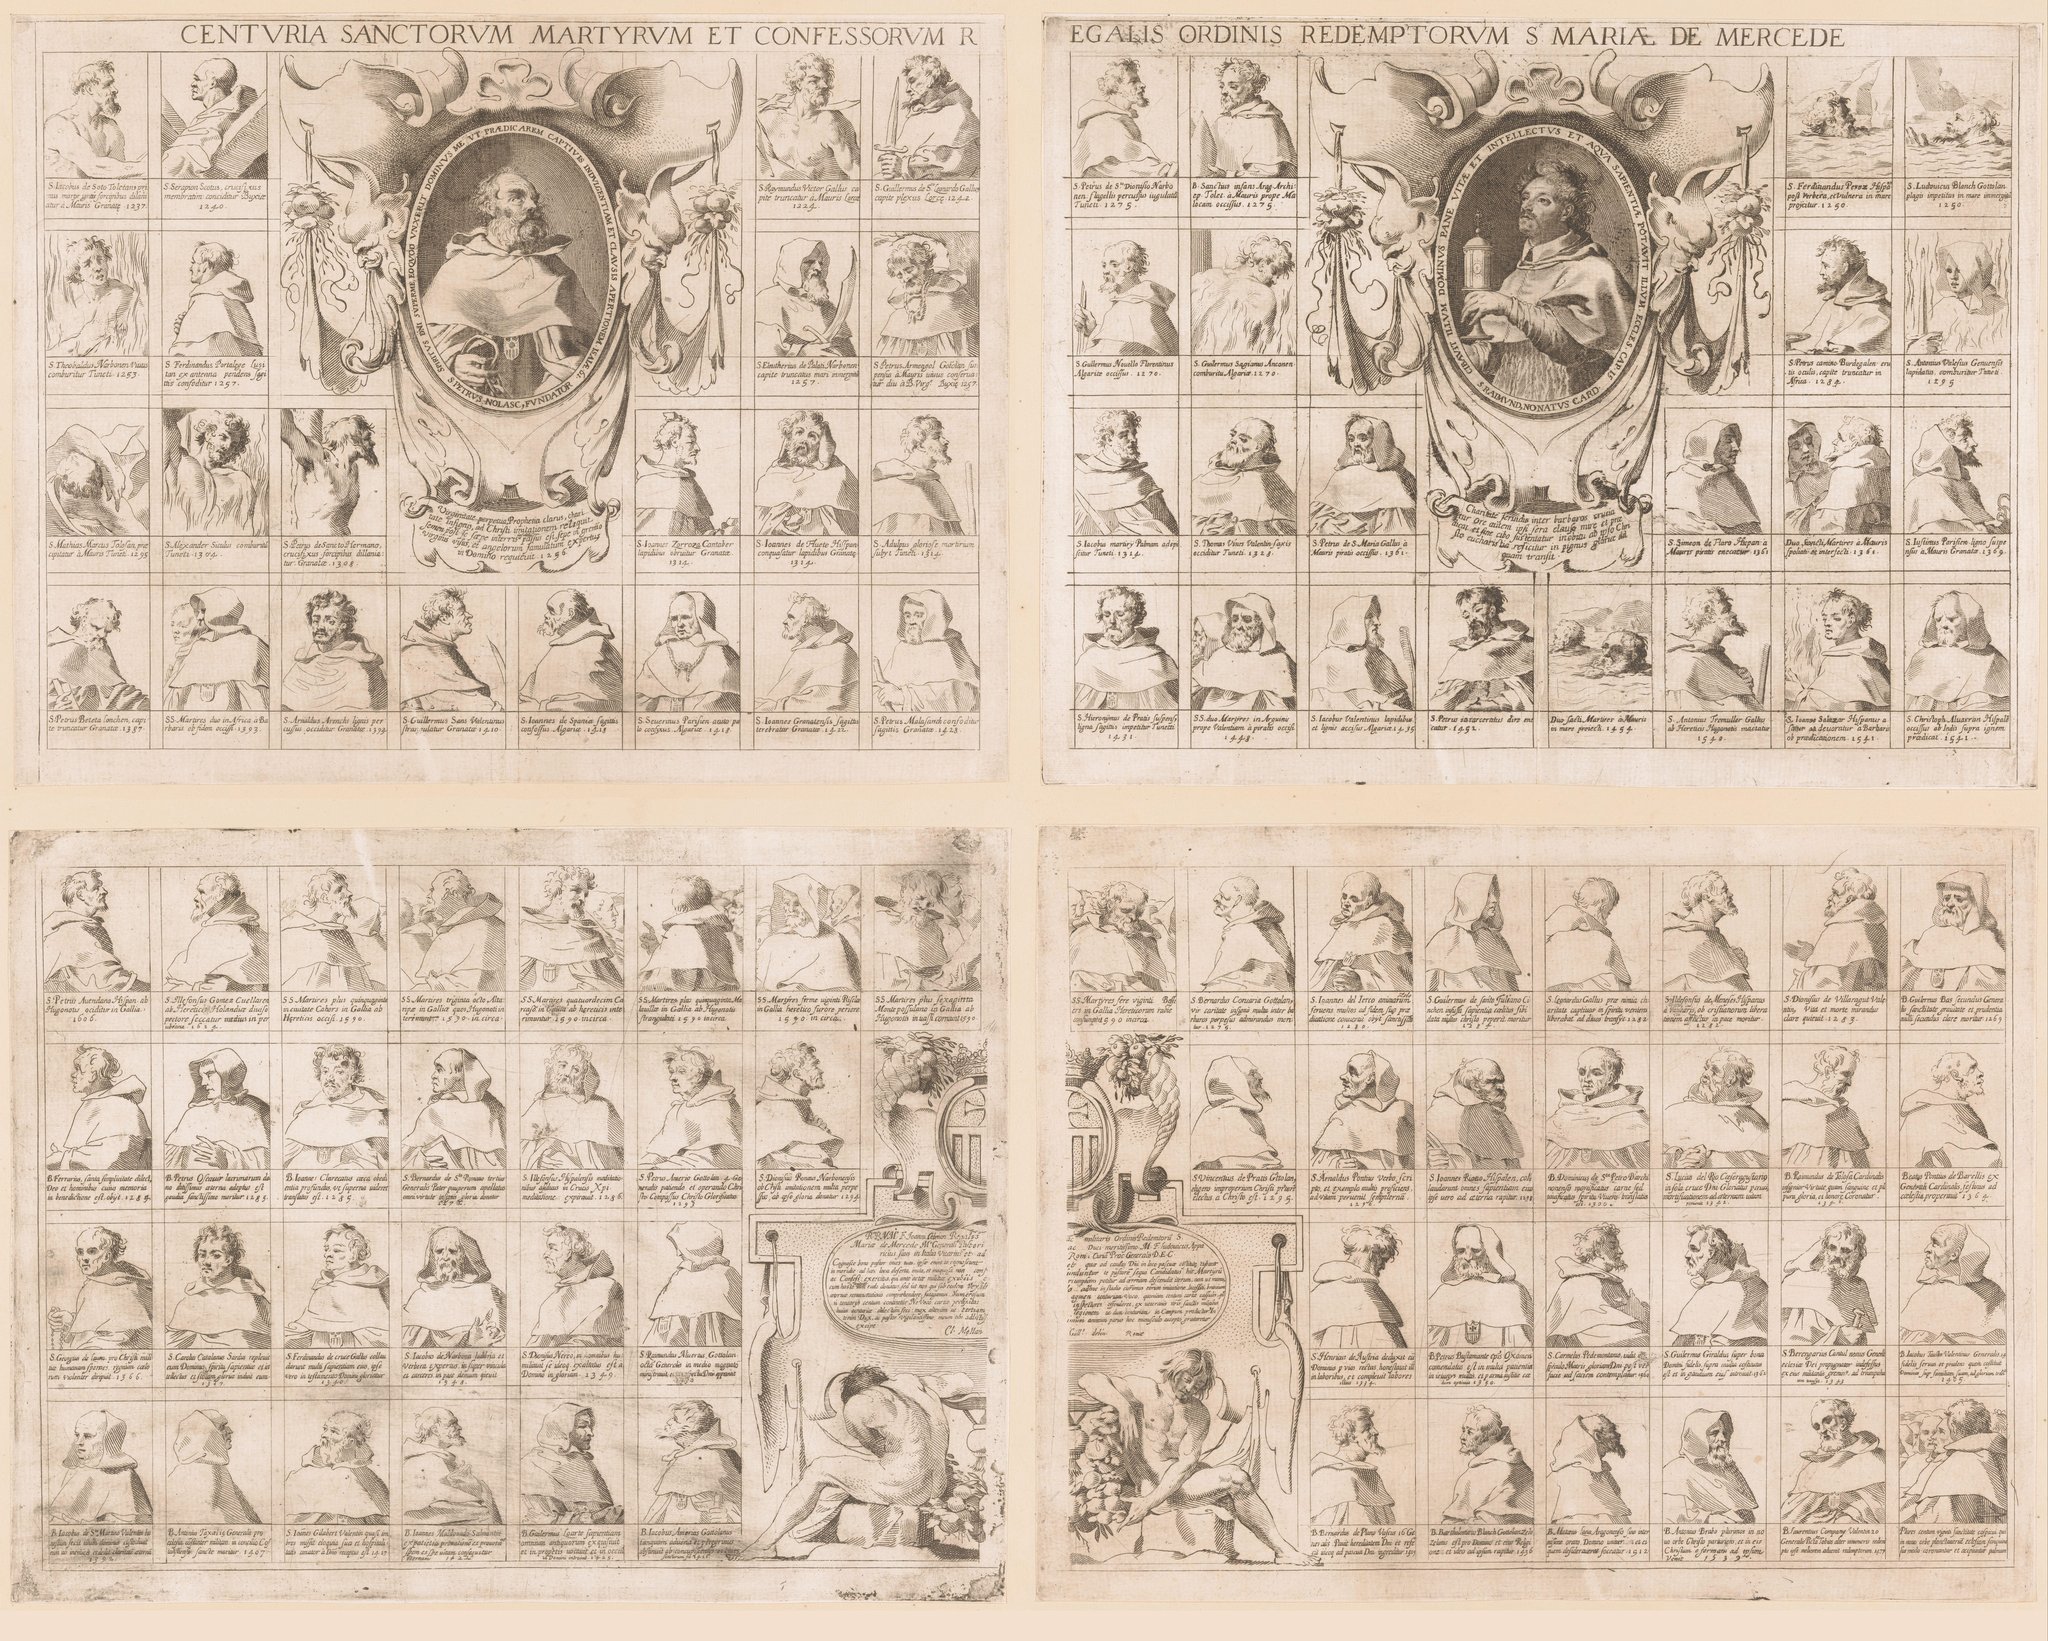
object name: print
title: Centuria Sanctorum Martyrum Et Confessorum Regalis Ordinis Redemptorum S. Maria De Mercede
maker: claude mellan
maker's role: draughtsman, print maker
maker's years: 1598-1688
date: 1624-1636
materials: paper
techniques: engraving, etching, intaglio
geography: rome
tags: saints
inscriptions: collector's mark: Lugt 240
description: Geheel bestaande uit vier platen met 98 martelaren van de Orde van Notre-Dame-de-la-Merci, ook wel Mercedariërs genoemd, met twee portretten van Peter Nolasco en Raymundus Nonnatus in ovalen.